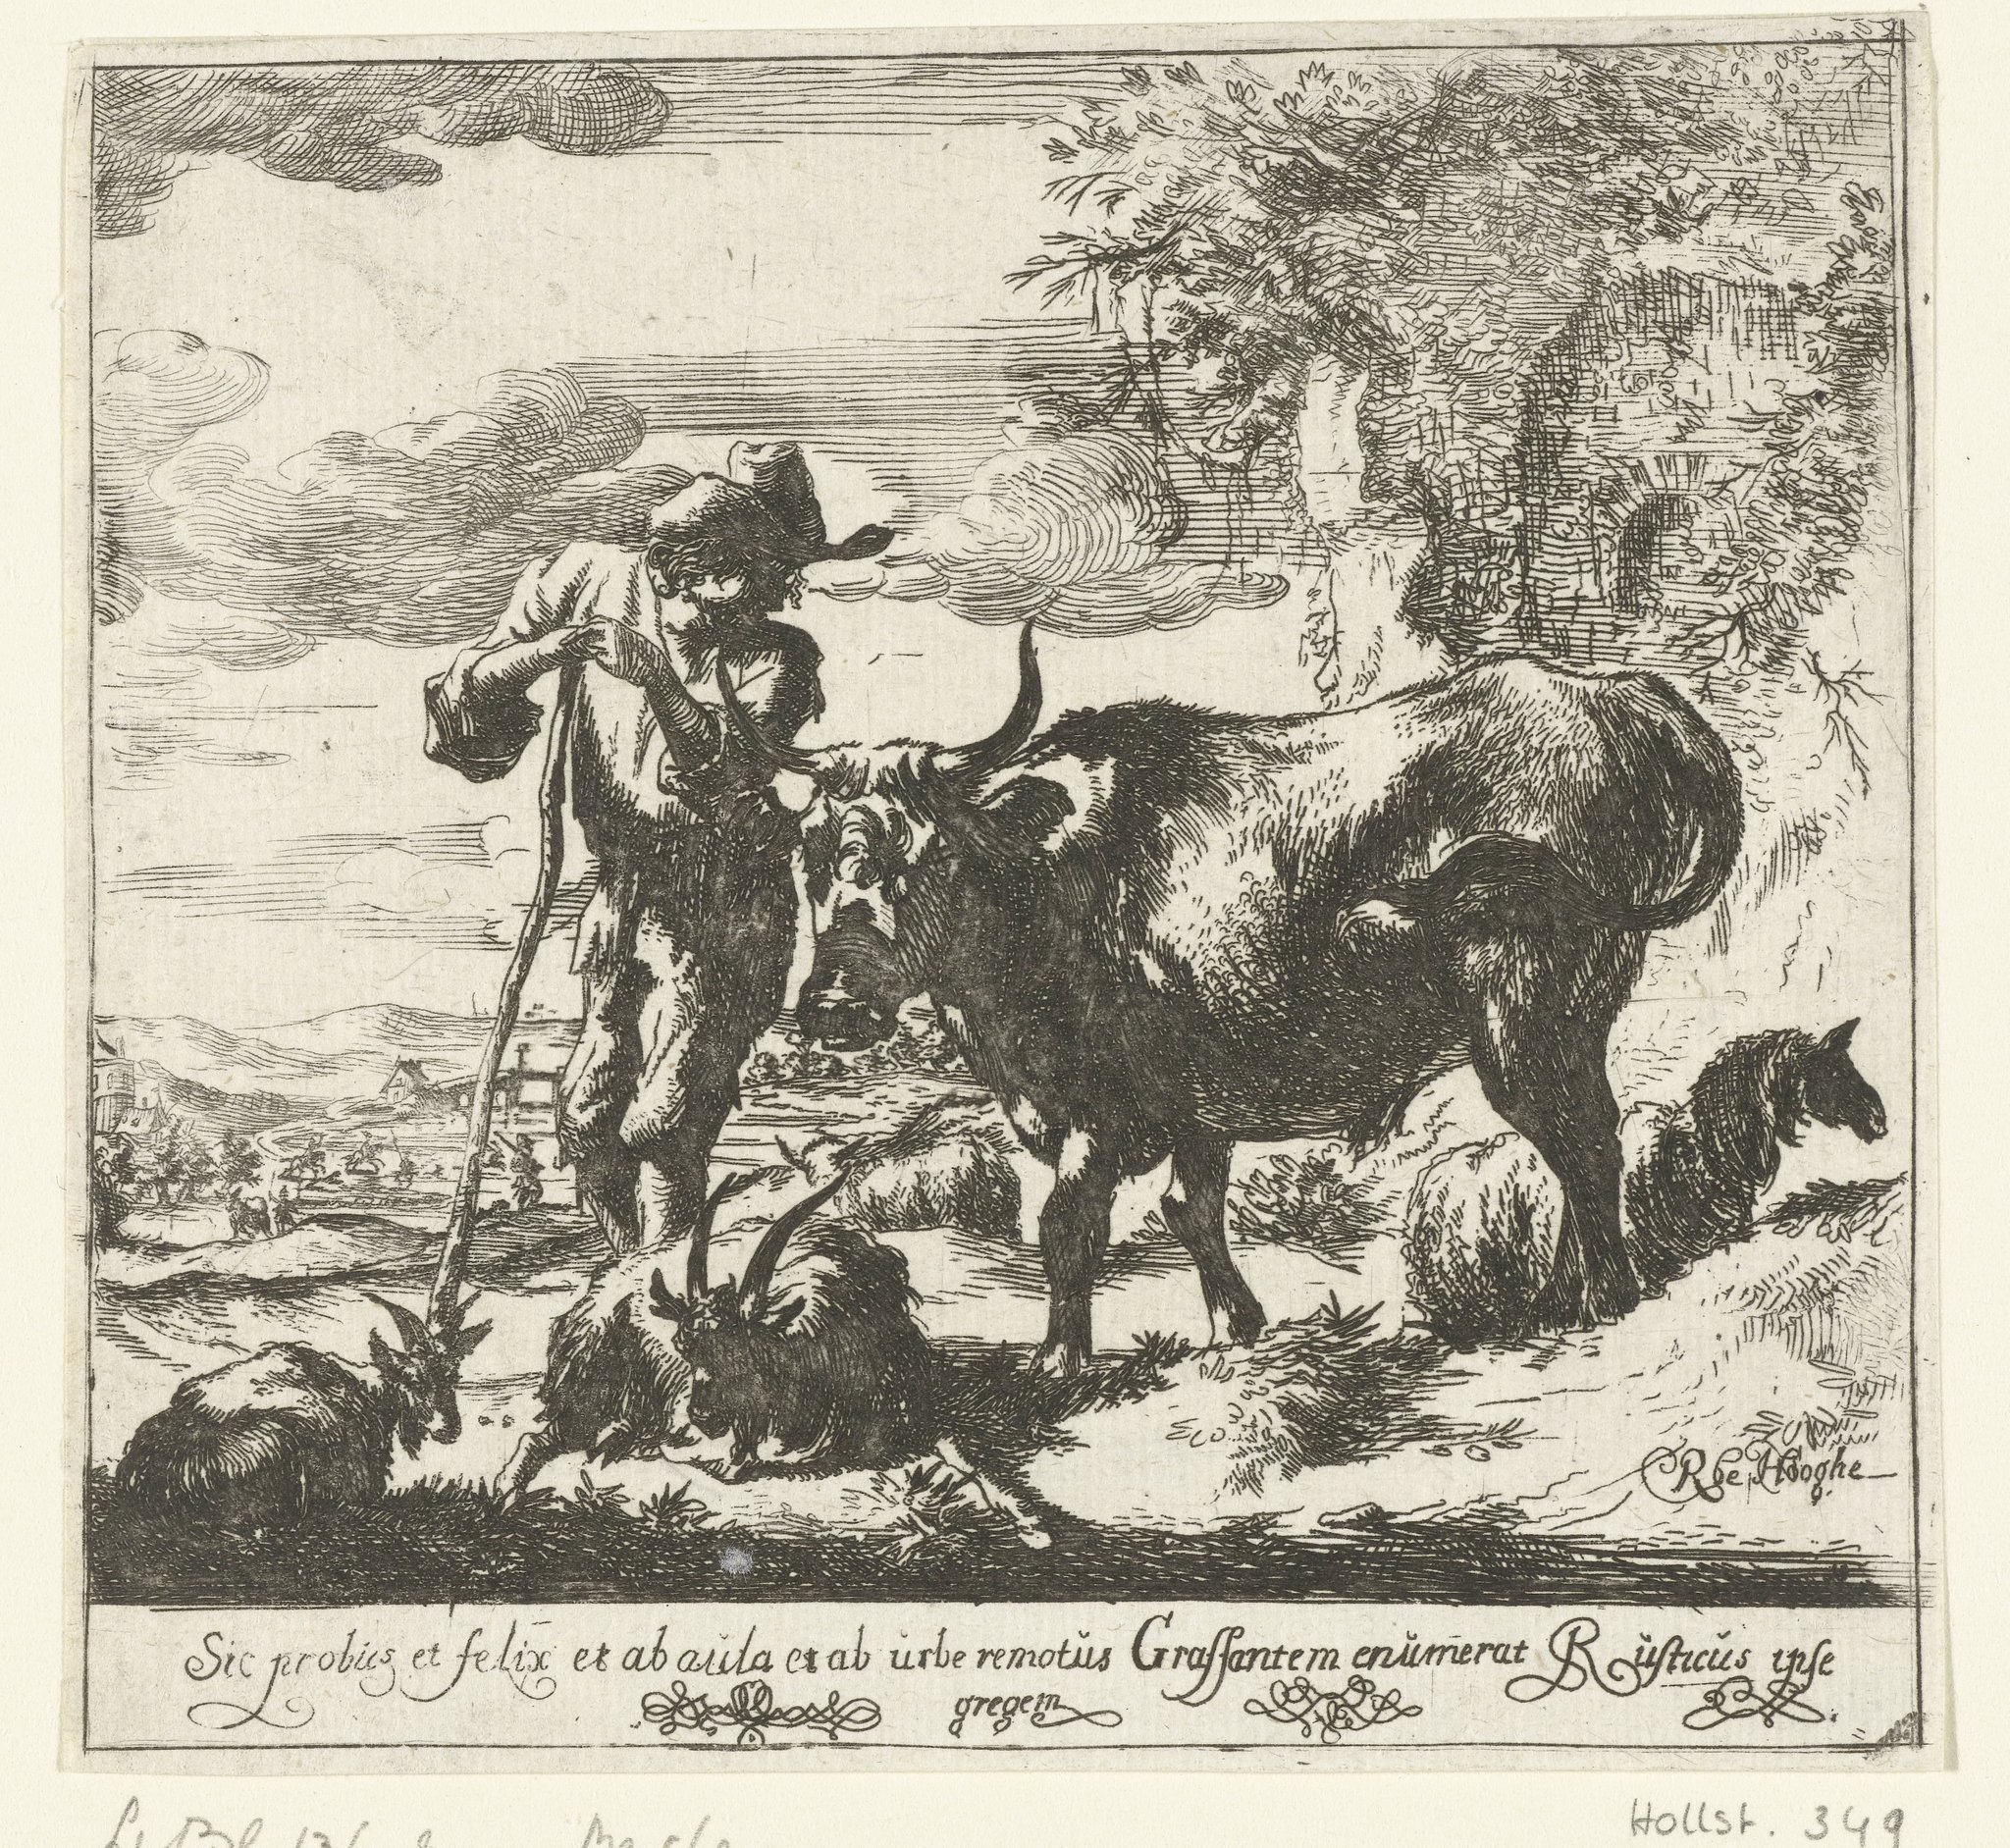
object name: print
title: Een herder met een koe, twee geiten en een schaap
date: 1655-1667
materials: paper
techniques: etching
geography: netherlands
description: Een herder met een koe, twee geiten en een schaap